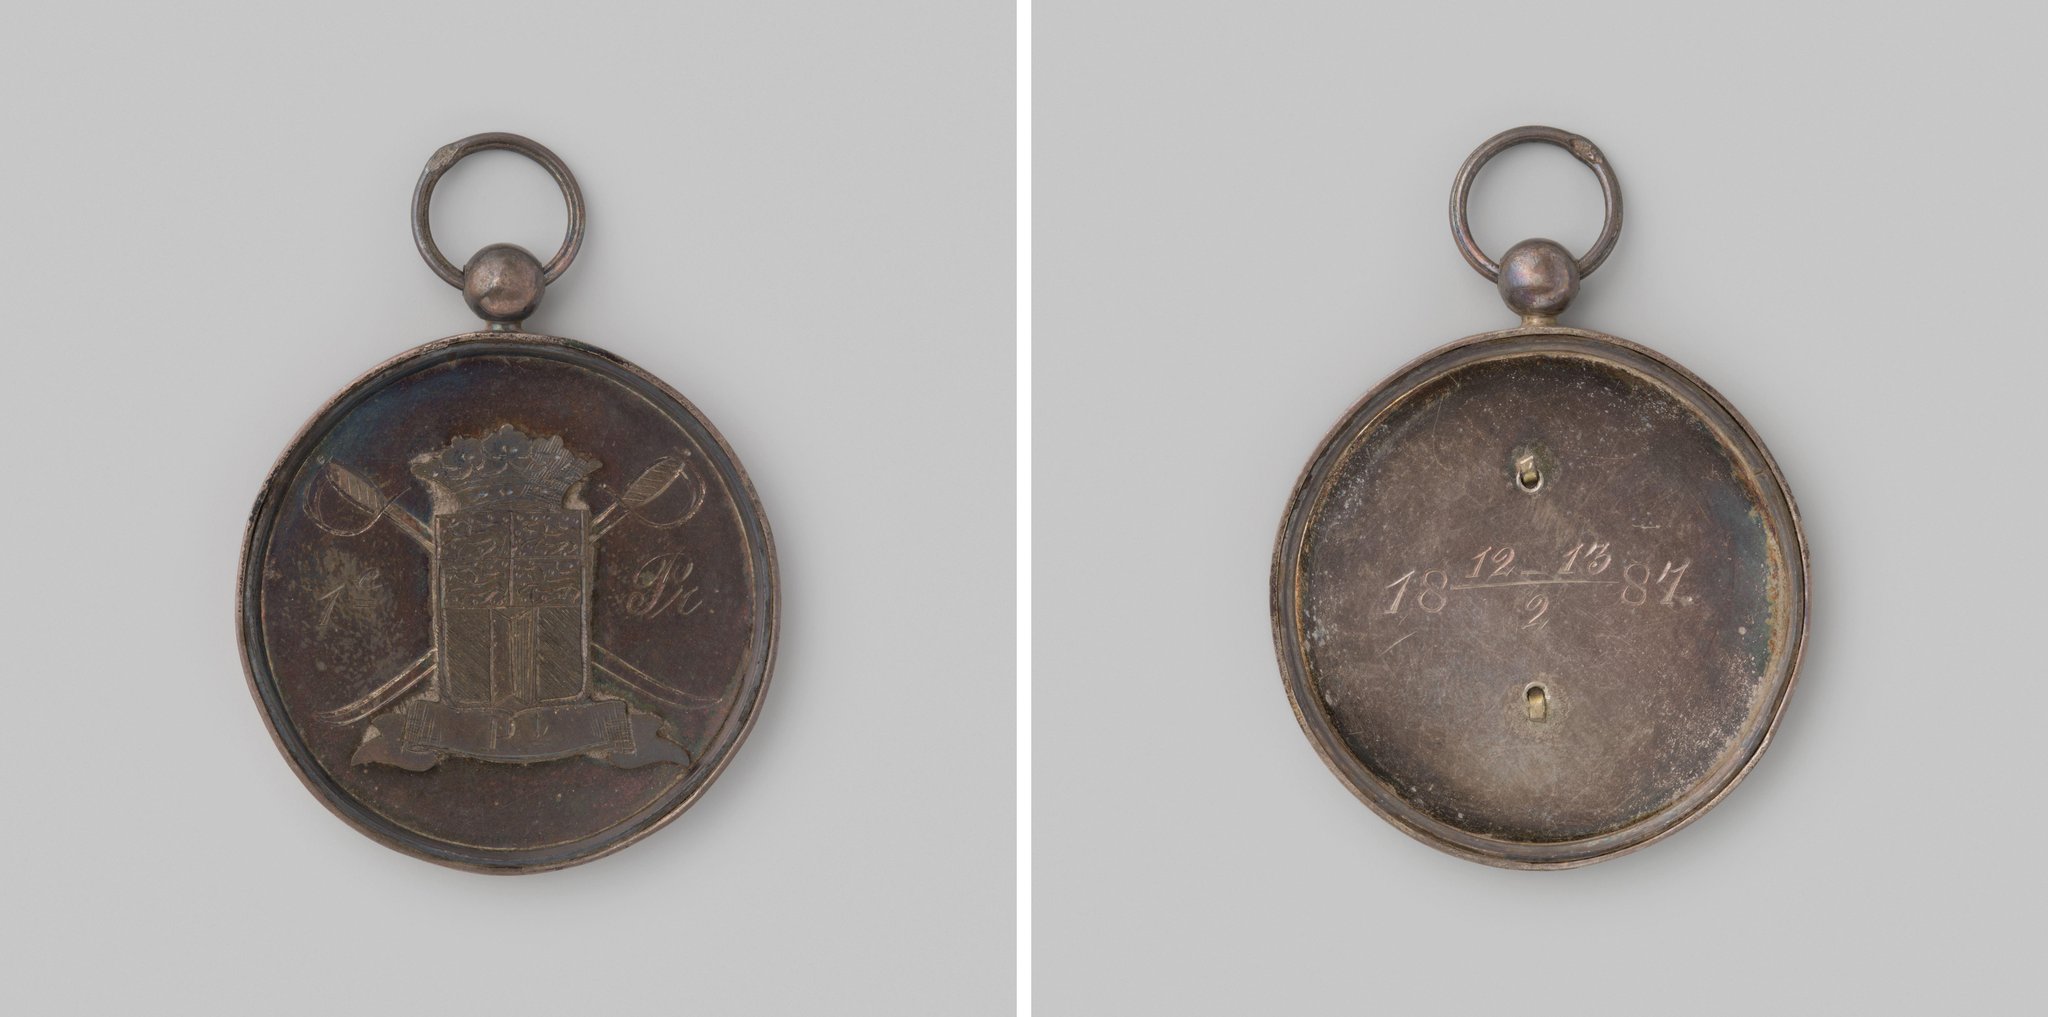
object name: medal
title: Prijspenning te Rotterdam uitgeloofd en behaald, personele prijs voor prevot op de sabel, eerste prijs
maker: Anonymous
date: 1897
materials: silver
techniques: gilding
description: Zilveren penning met verguld zilveren wapen met kroon, met knop en ring.